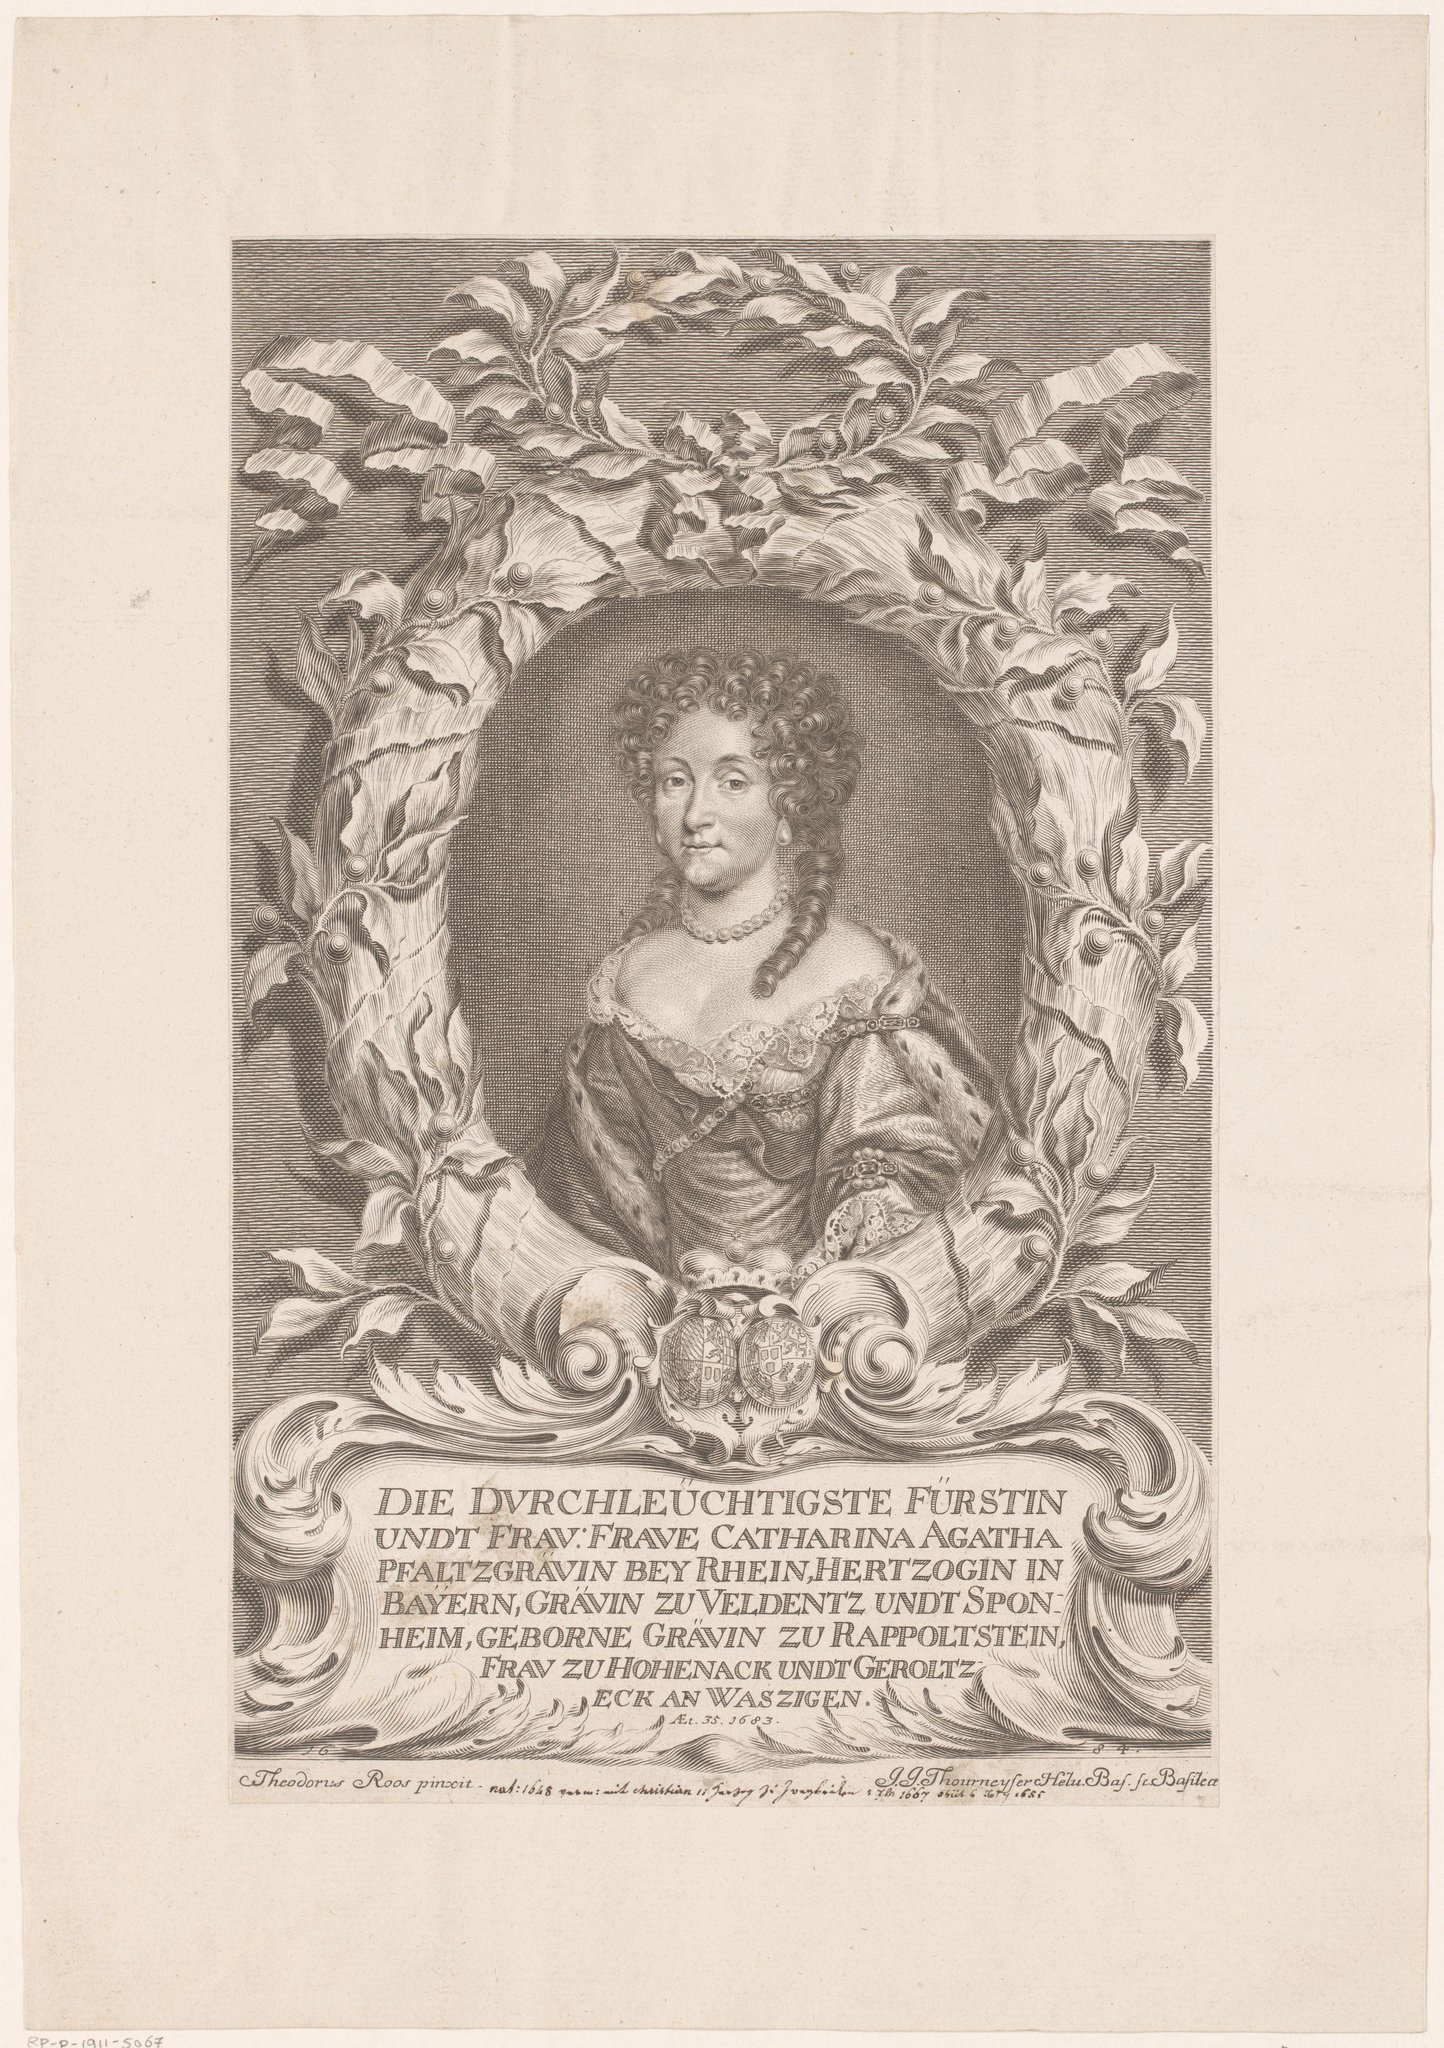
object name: print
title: Portret van Catherina Agatha von Rappollstein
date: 1684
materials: paper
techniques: engraving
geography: basel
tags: historical persons - bb - woman, historical persons, armorial bearing, heraldry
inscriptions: collector's mark: Lugt 9, collector's mark: Lugt 2228